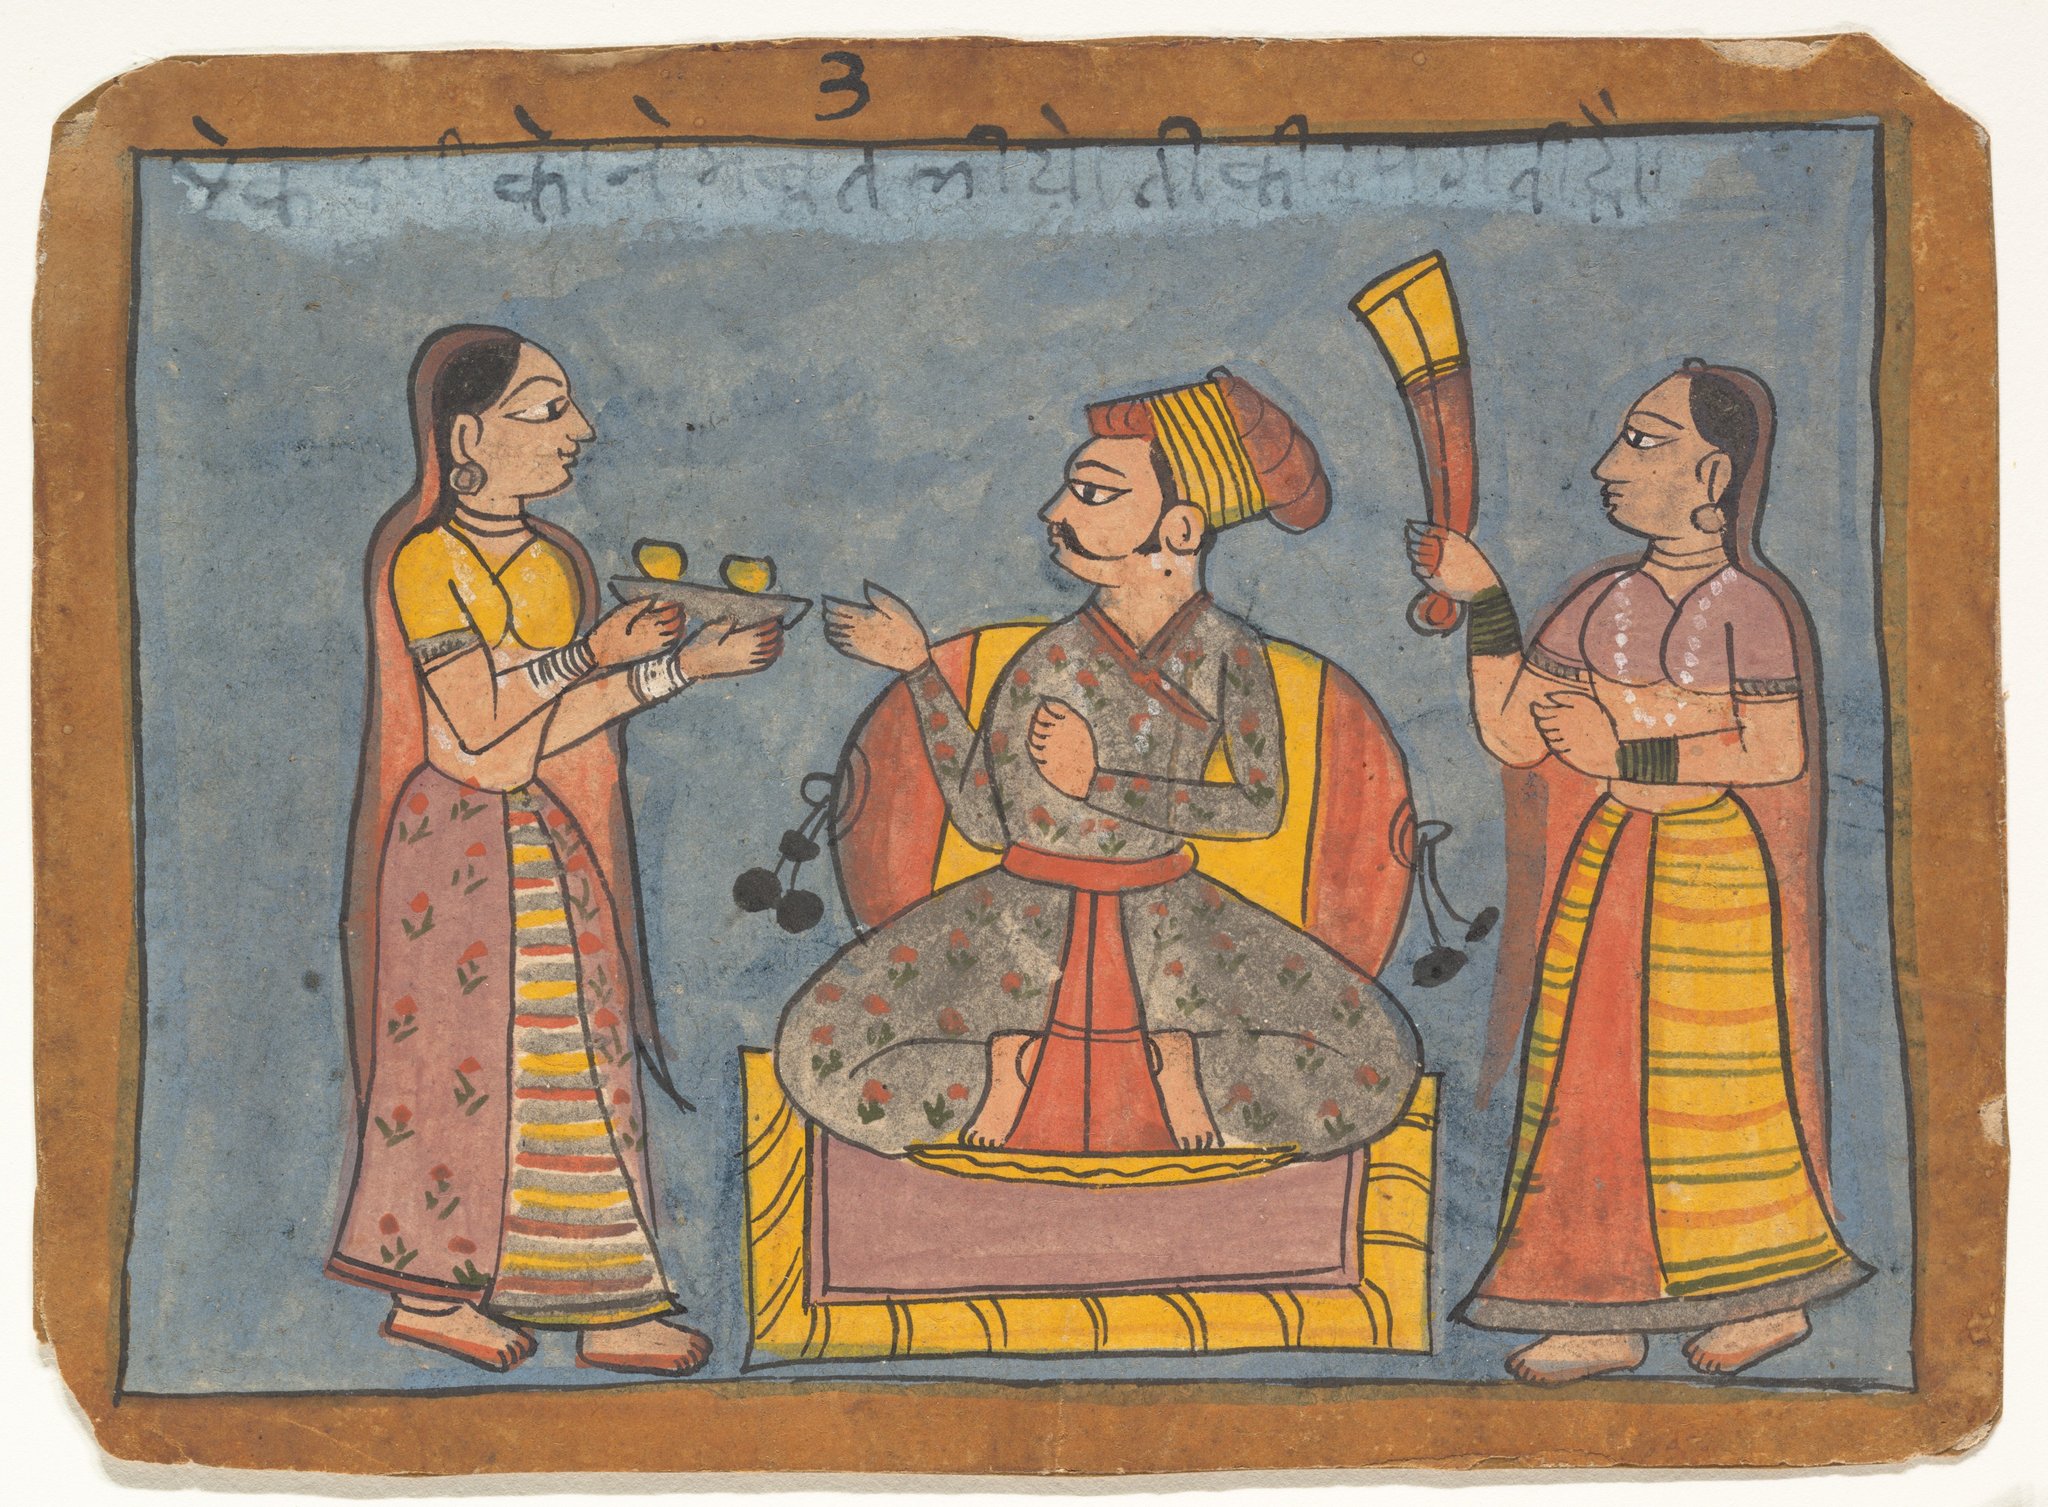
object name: painting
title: Folk Painting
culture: indian, rajasthan, marwar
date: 1725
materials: ink, paper, watercolor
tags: food,fruit,men,women